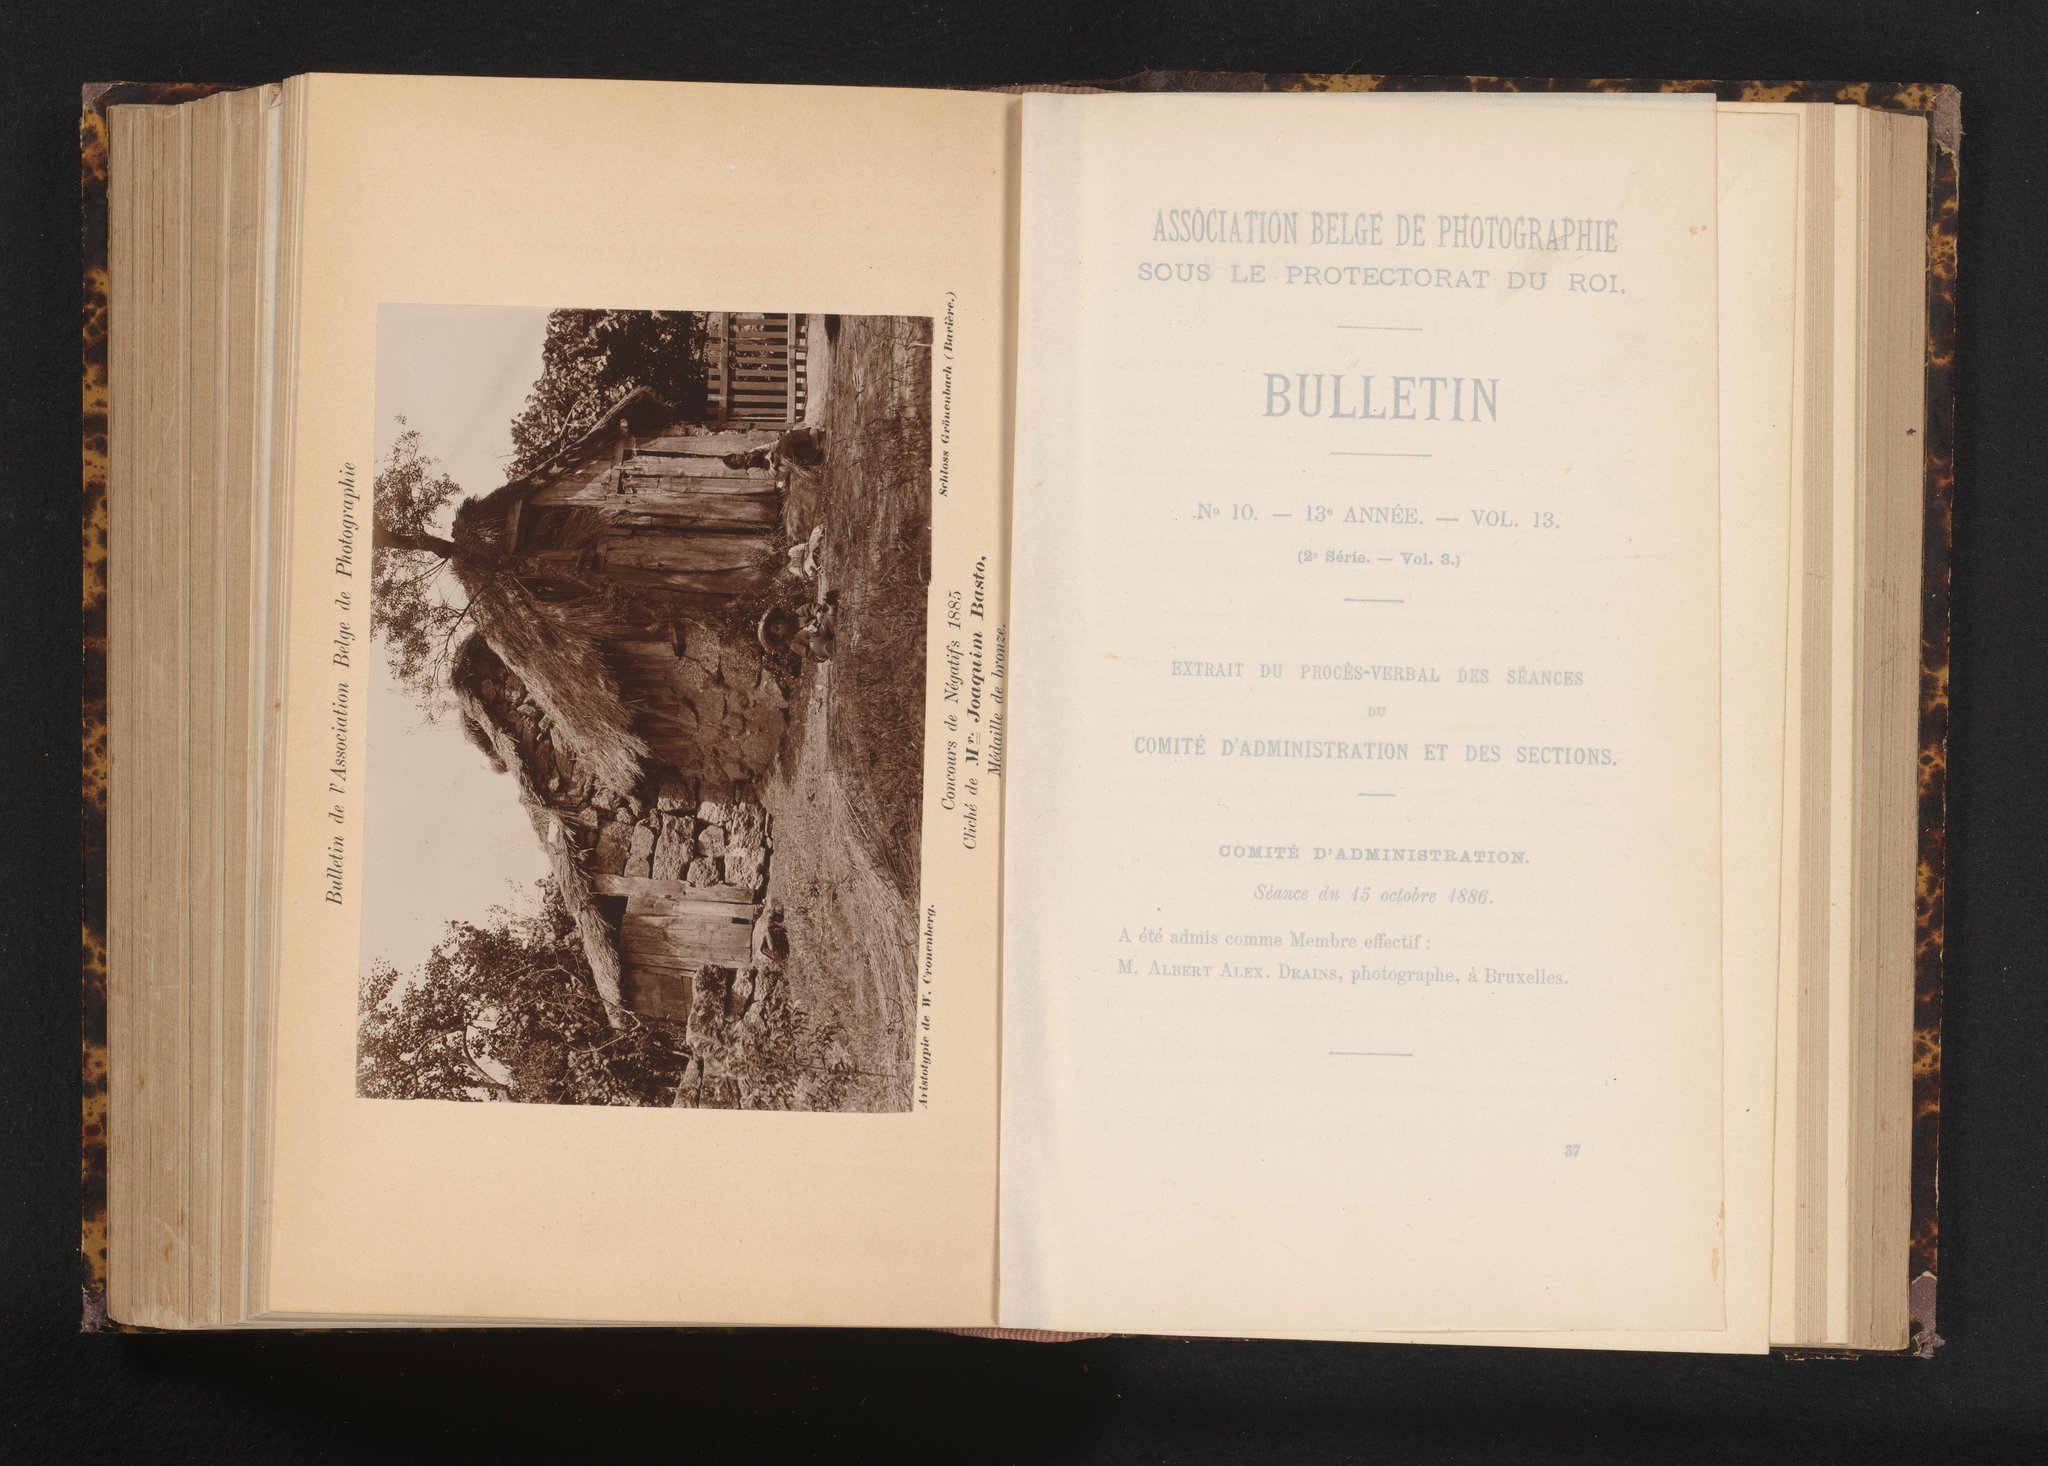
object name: page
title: Twee onbekende kinderen en een vrouw voor een woning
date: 1881-1886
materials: paper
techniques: collodion silver print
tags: historical persons, housing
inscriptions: inscription: ‘Concours de négatifs 1885/ Médaille de bronze’, inscription: ‘Bulletin de l'association belge de photographie / Schloss-Gronenbach (Bavière )’